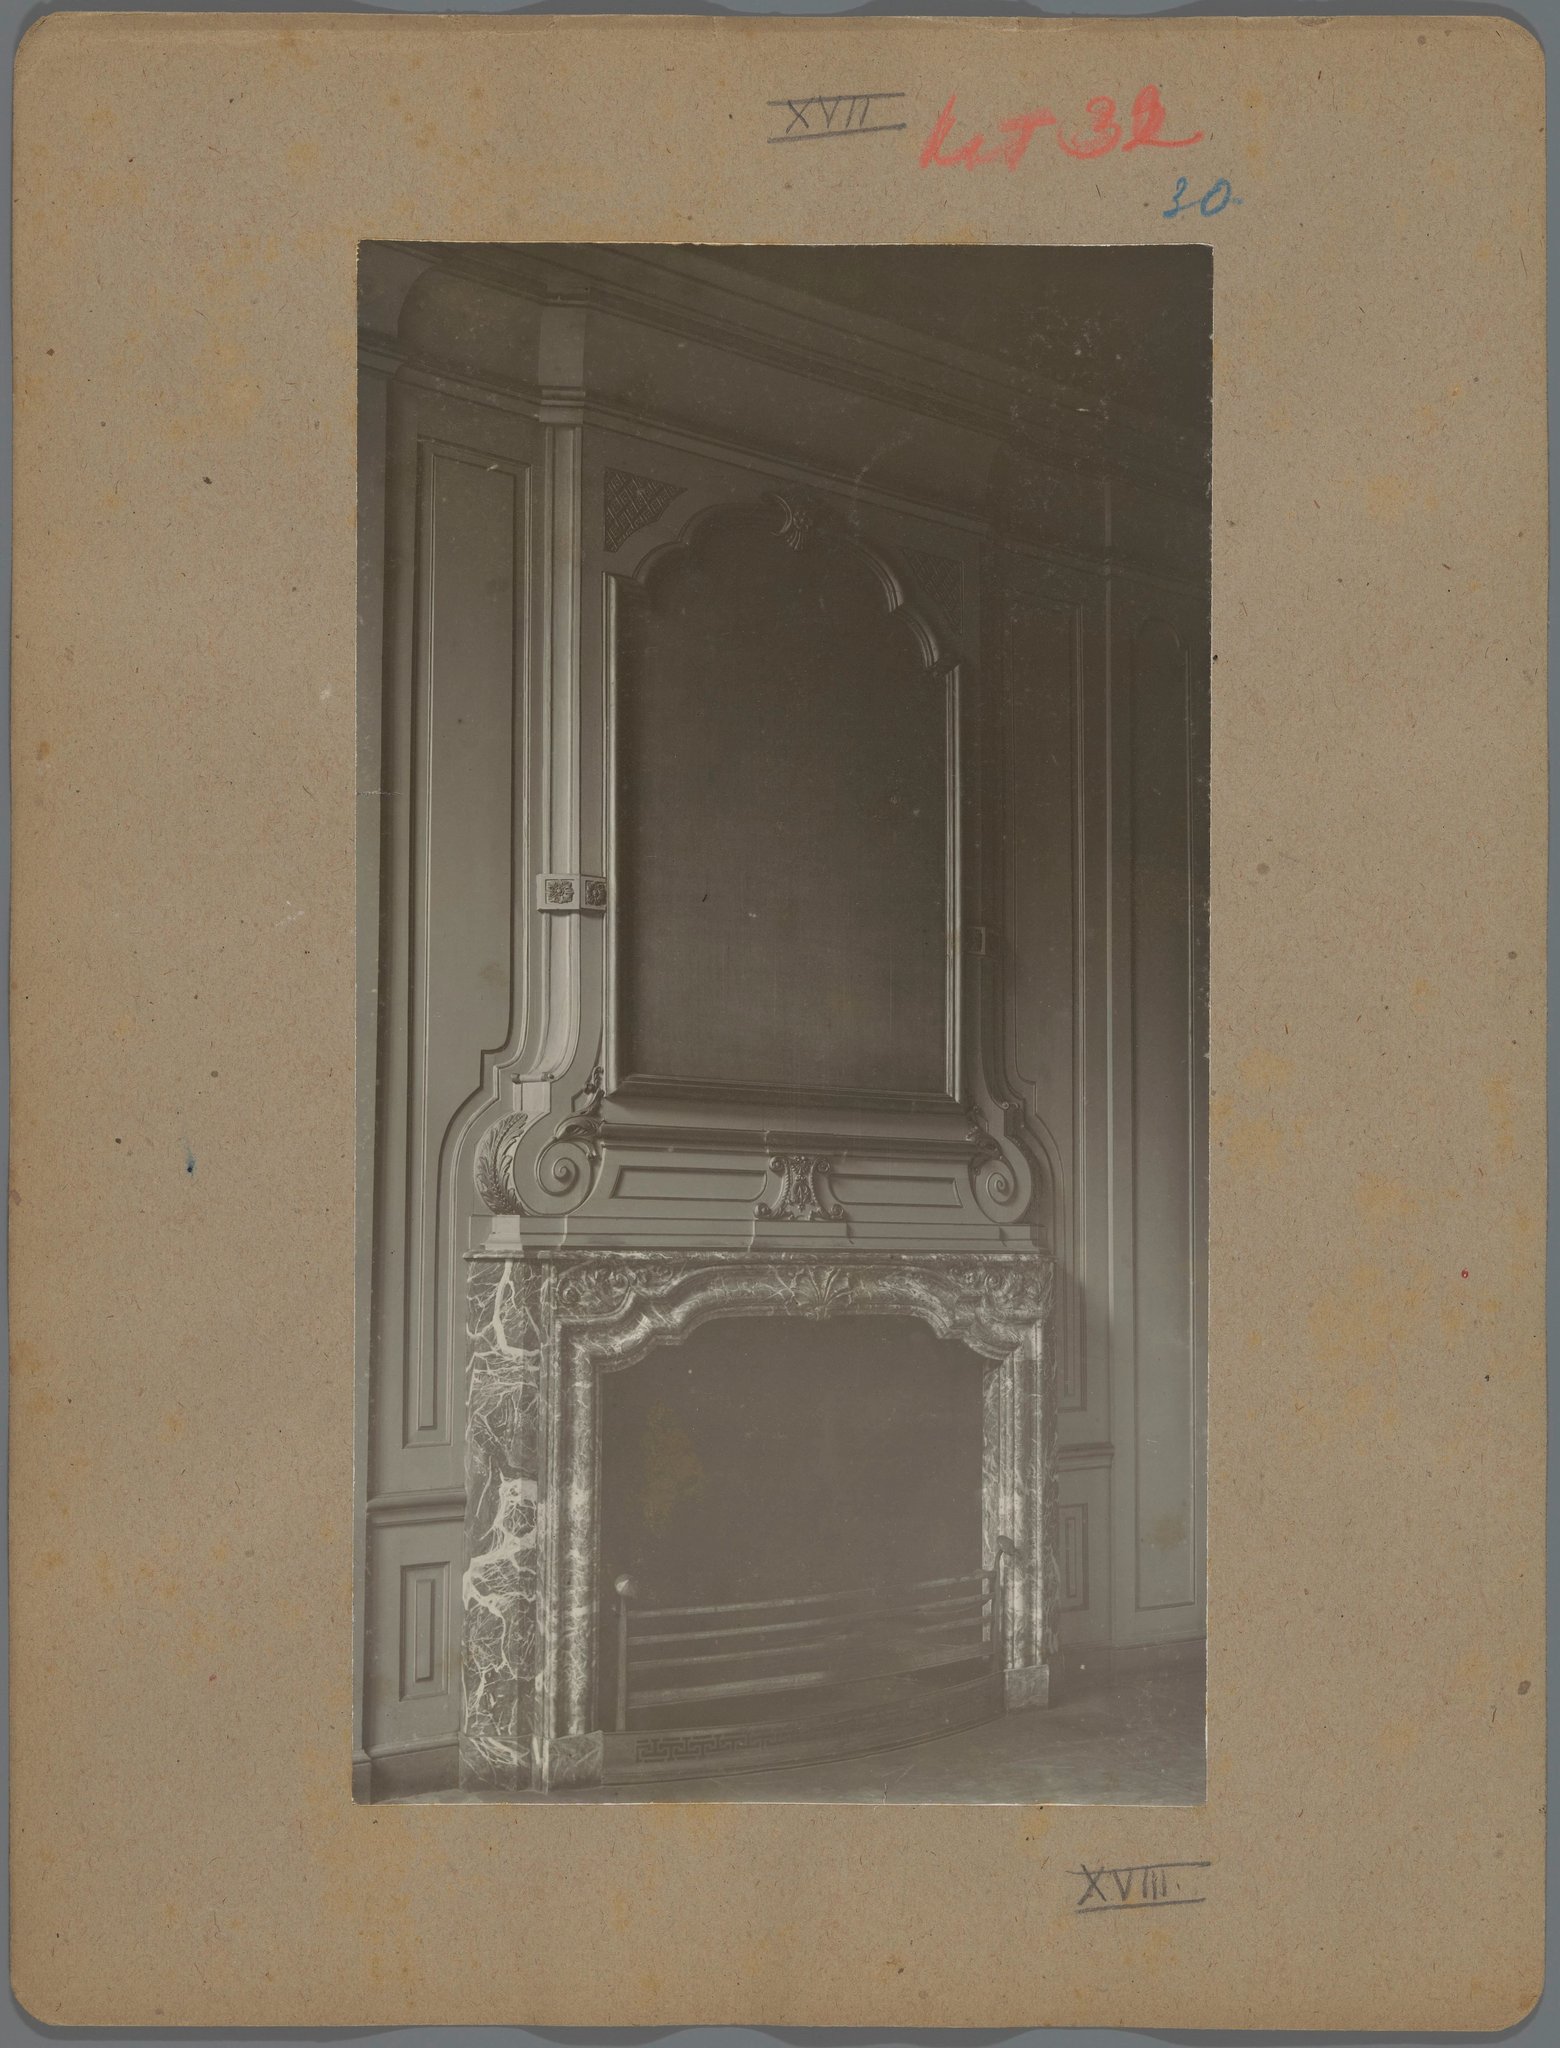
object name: photograph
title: Schouw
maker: Anonymous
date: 1875-1900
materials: cardboard, photographic support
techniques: gelatin silver print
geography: europe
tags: open hearth, fire-place, europe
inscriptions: number: ‘30’, number: ‘XVII’, collector's mark: ‘INSTITUUT VOOR KUNST-NIJVERHEIDSONDERWIJS GABRIËL METSUSTRAAT No. 16 AMSTERDAM’, number: ‘Kat 32’, collector's mark: ‘KUNSTNIJVERHEIDSCHOOL QUELLINUS AMSTERDAM FRANS HALSSTRAAT 14.’, number: ‘XVIII’